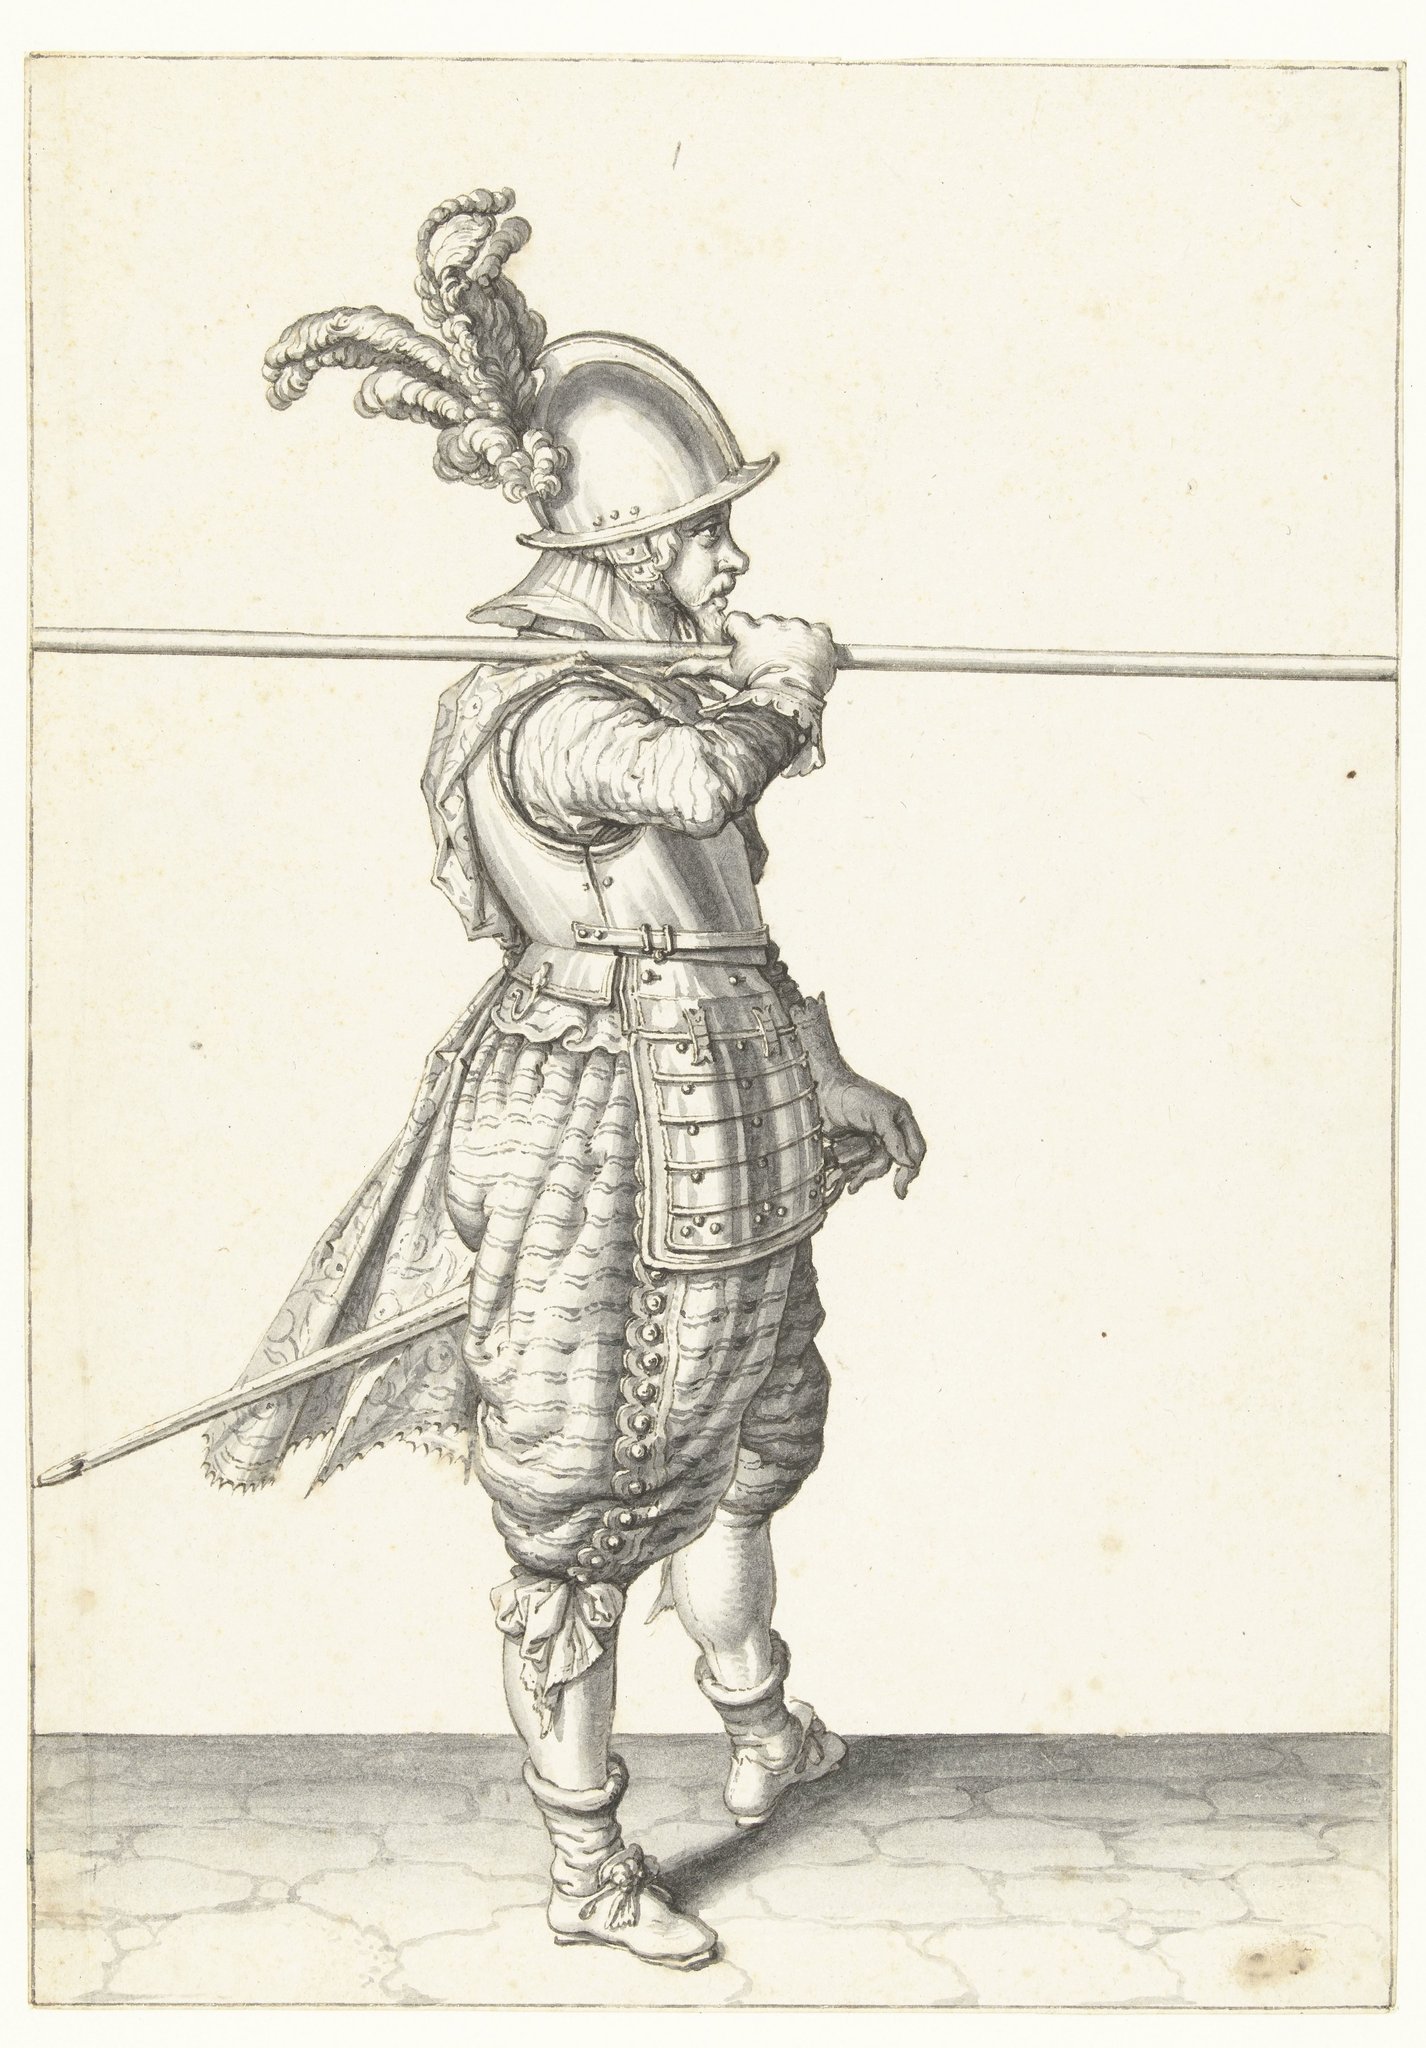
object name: drawing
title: Soldaat die zijn spies horizontaal op zijn rechterschouder draagt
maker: jacques de gheyn (ii)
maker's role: painter, print maker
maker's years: 1565-1629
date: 1596-1606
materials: ink, paper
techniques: brush, pen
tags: the hague, maurice (prince of orange), handling of weapons ~ military training, weapons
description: Ontwerptekening voor de illustratie in: J. de Gheyn, Wapenhandelinghe van roers, musquetten ende spiessen achtervolgende de ordre van ... Maurits Prince van Orangie ... , [J. de Gheyn], 's-Gravenhage 1607. Derde deel: Corte onderwysinghe op de figuerliicke afbeeldinghe, belanghende t'recht ghebruyck, van al t'ghene een Soldaet int handelen vande Spies noodich is, plaat 26.